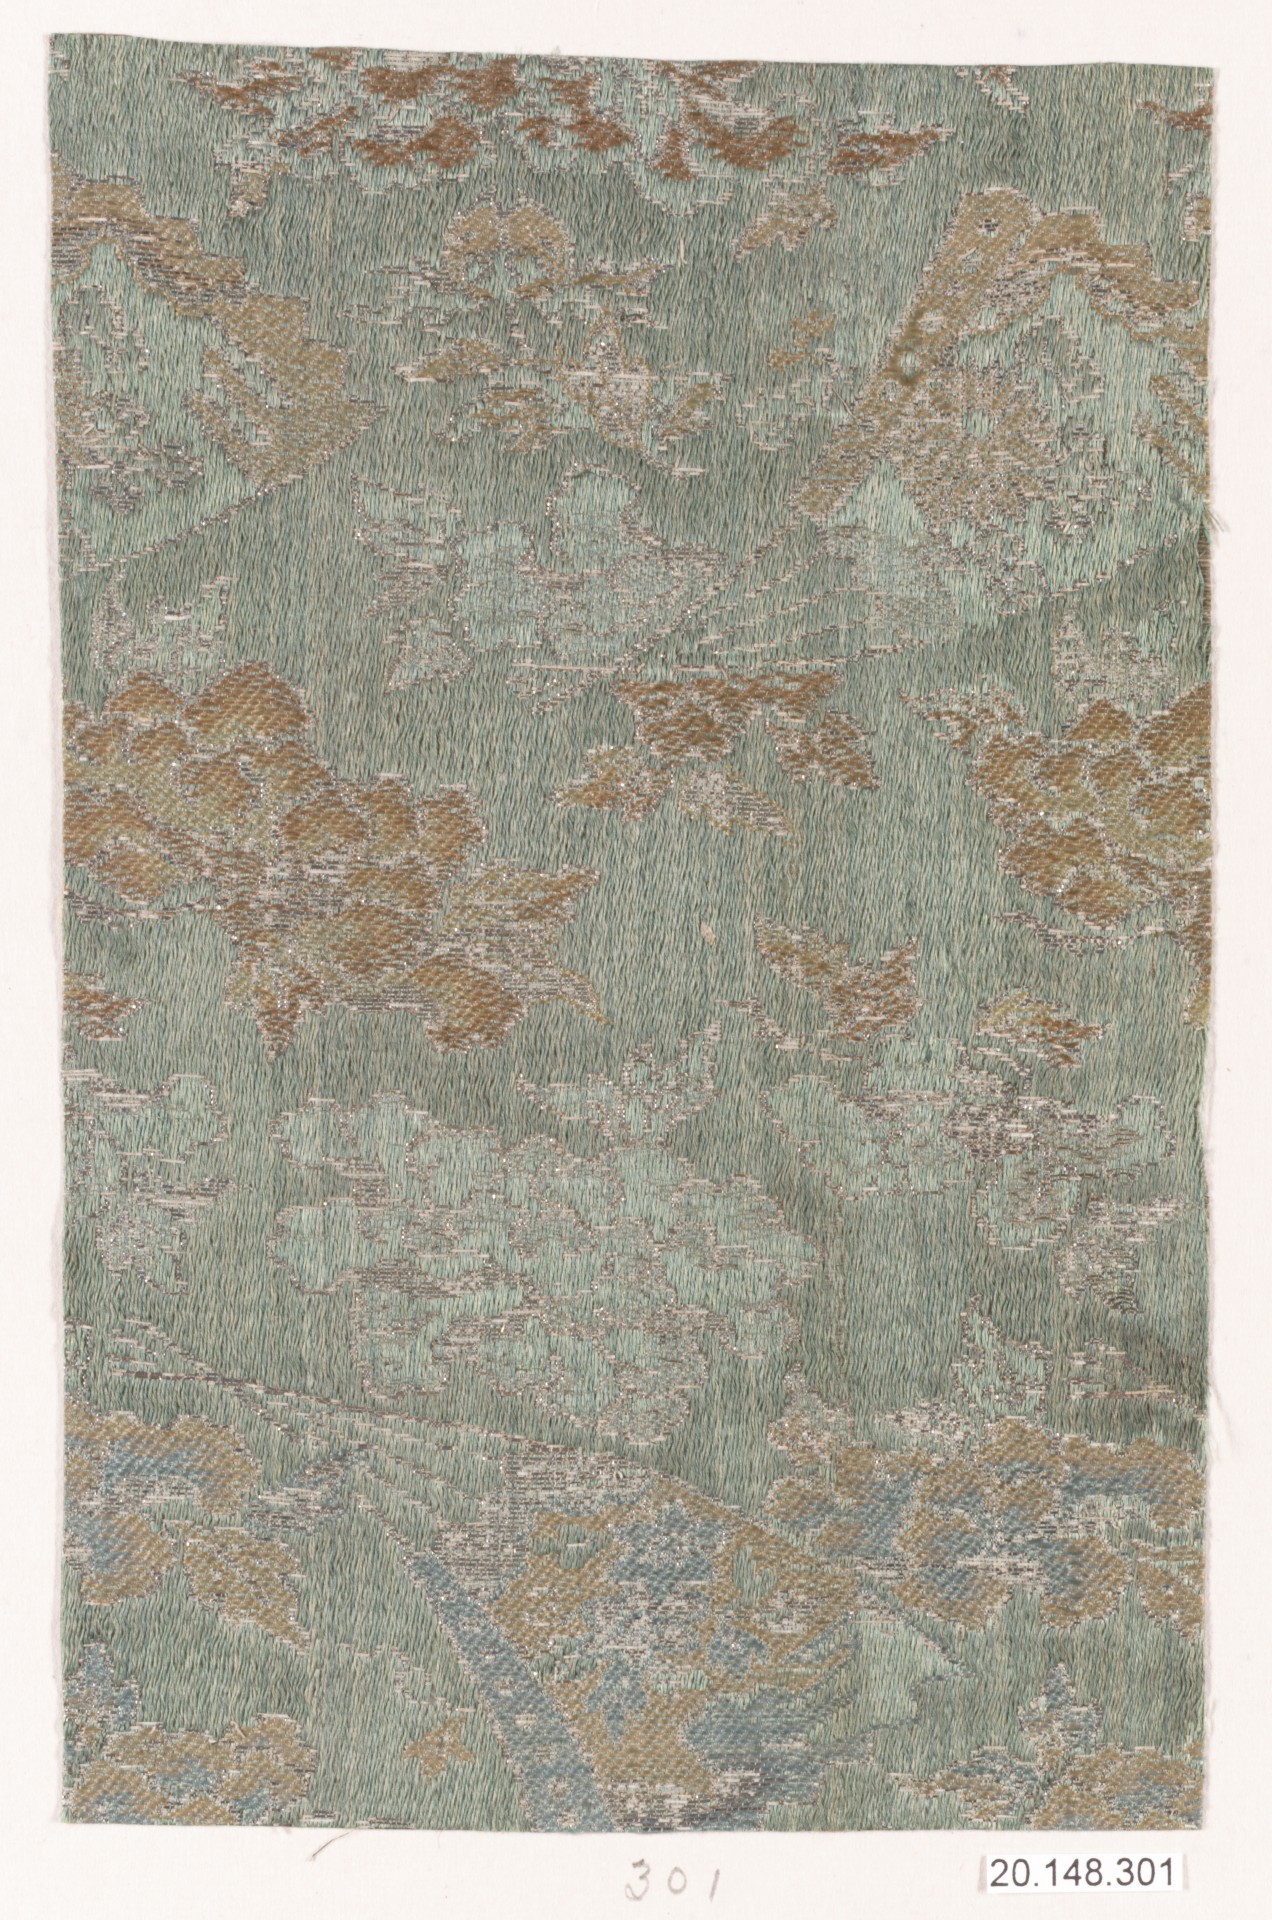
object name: piece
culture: japanese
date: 1701-1800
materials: silk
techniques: compound weave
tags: flowers